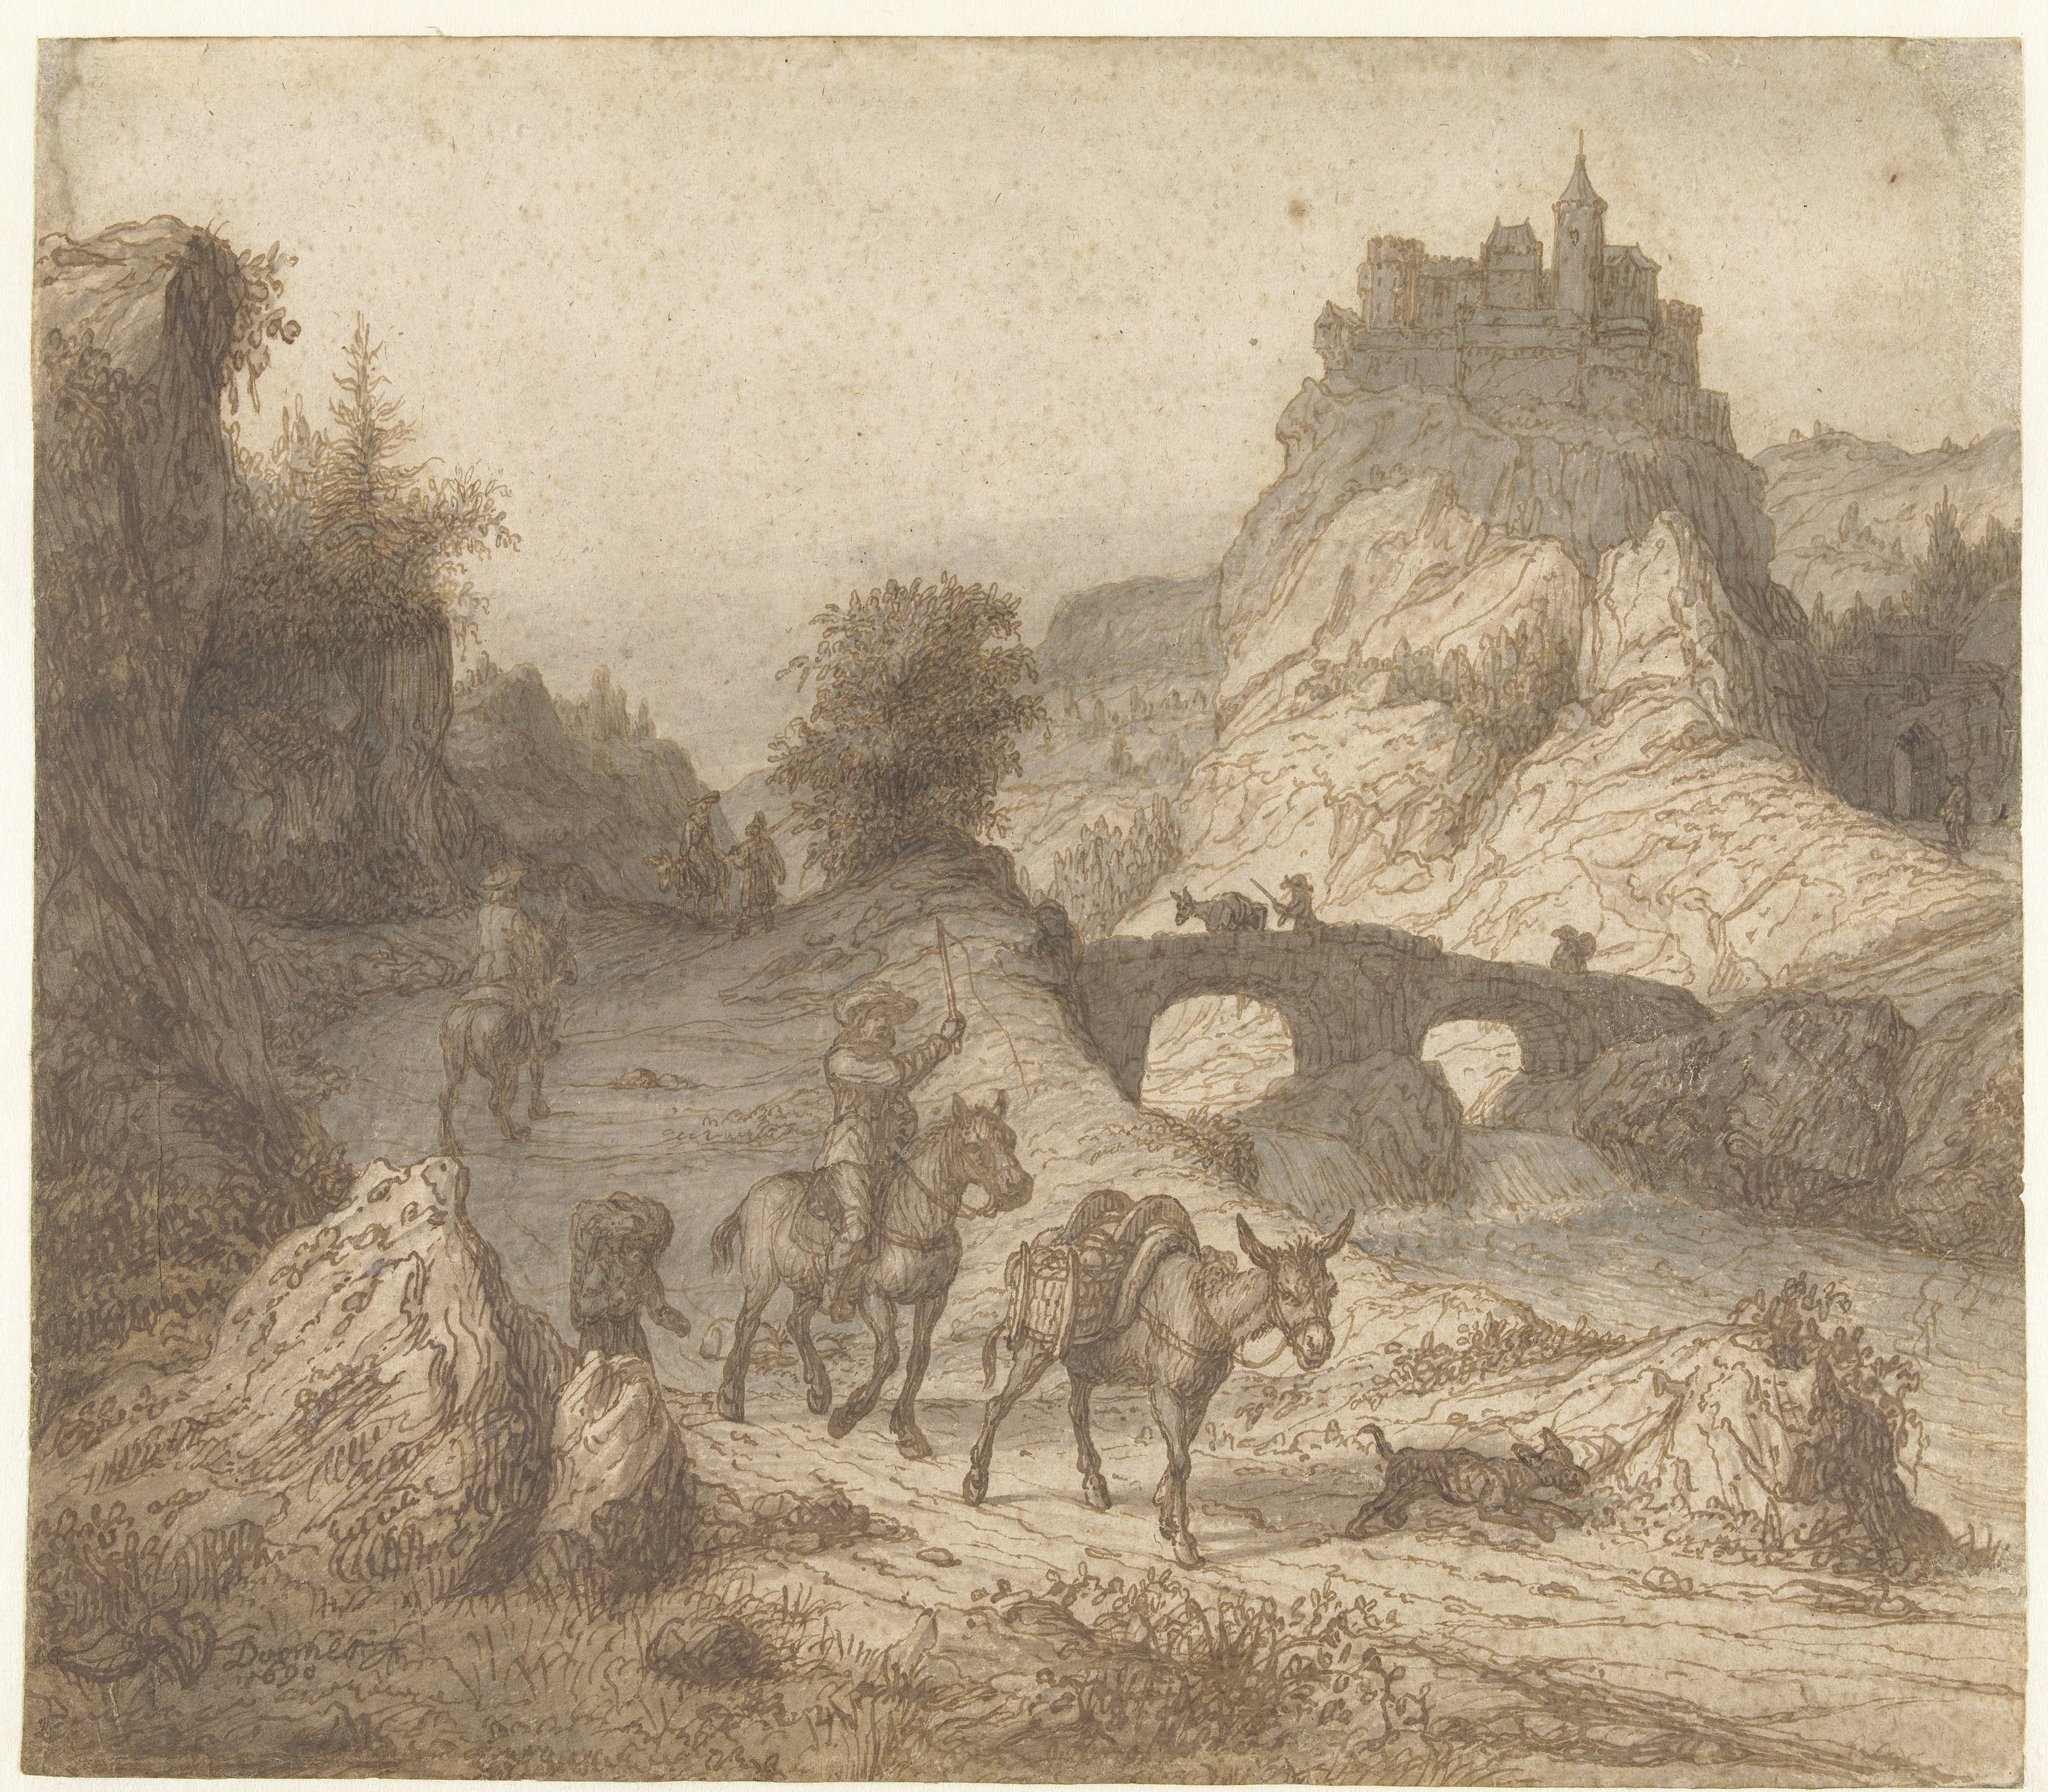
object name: drawing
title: Berglandschap met kasteel en figuren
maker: lambert doomer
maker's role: draughtsman, painter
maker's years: 1622-1700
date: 1690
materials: ink, paper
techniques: brush, pen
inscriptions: date: ‘1690’